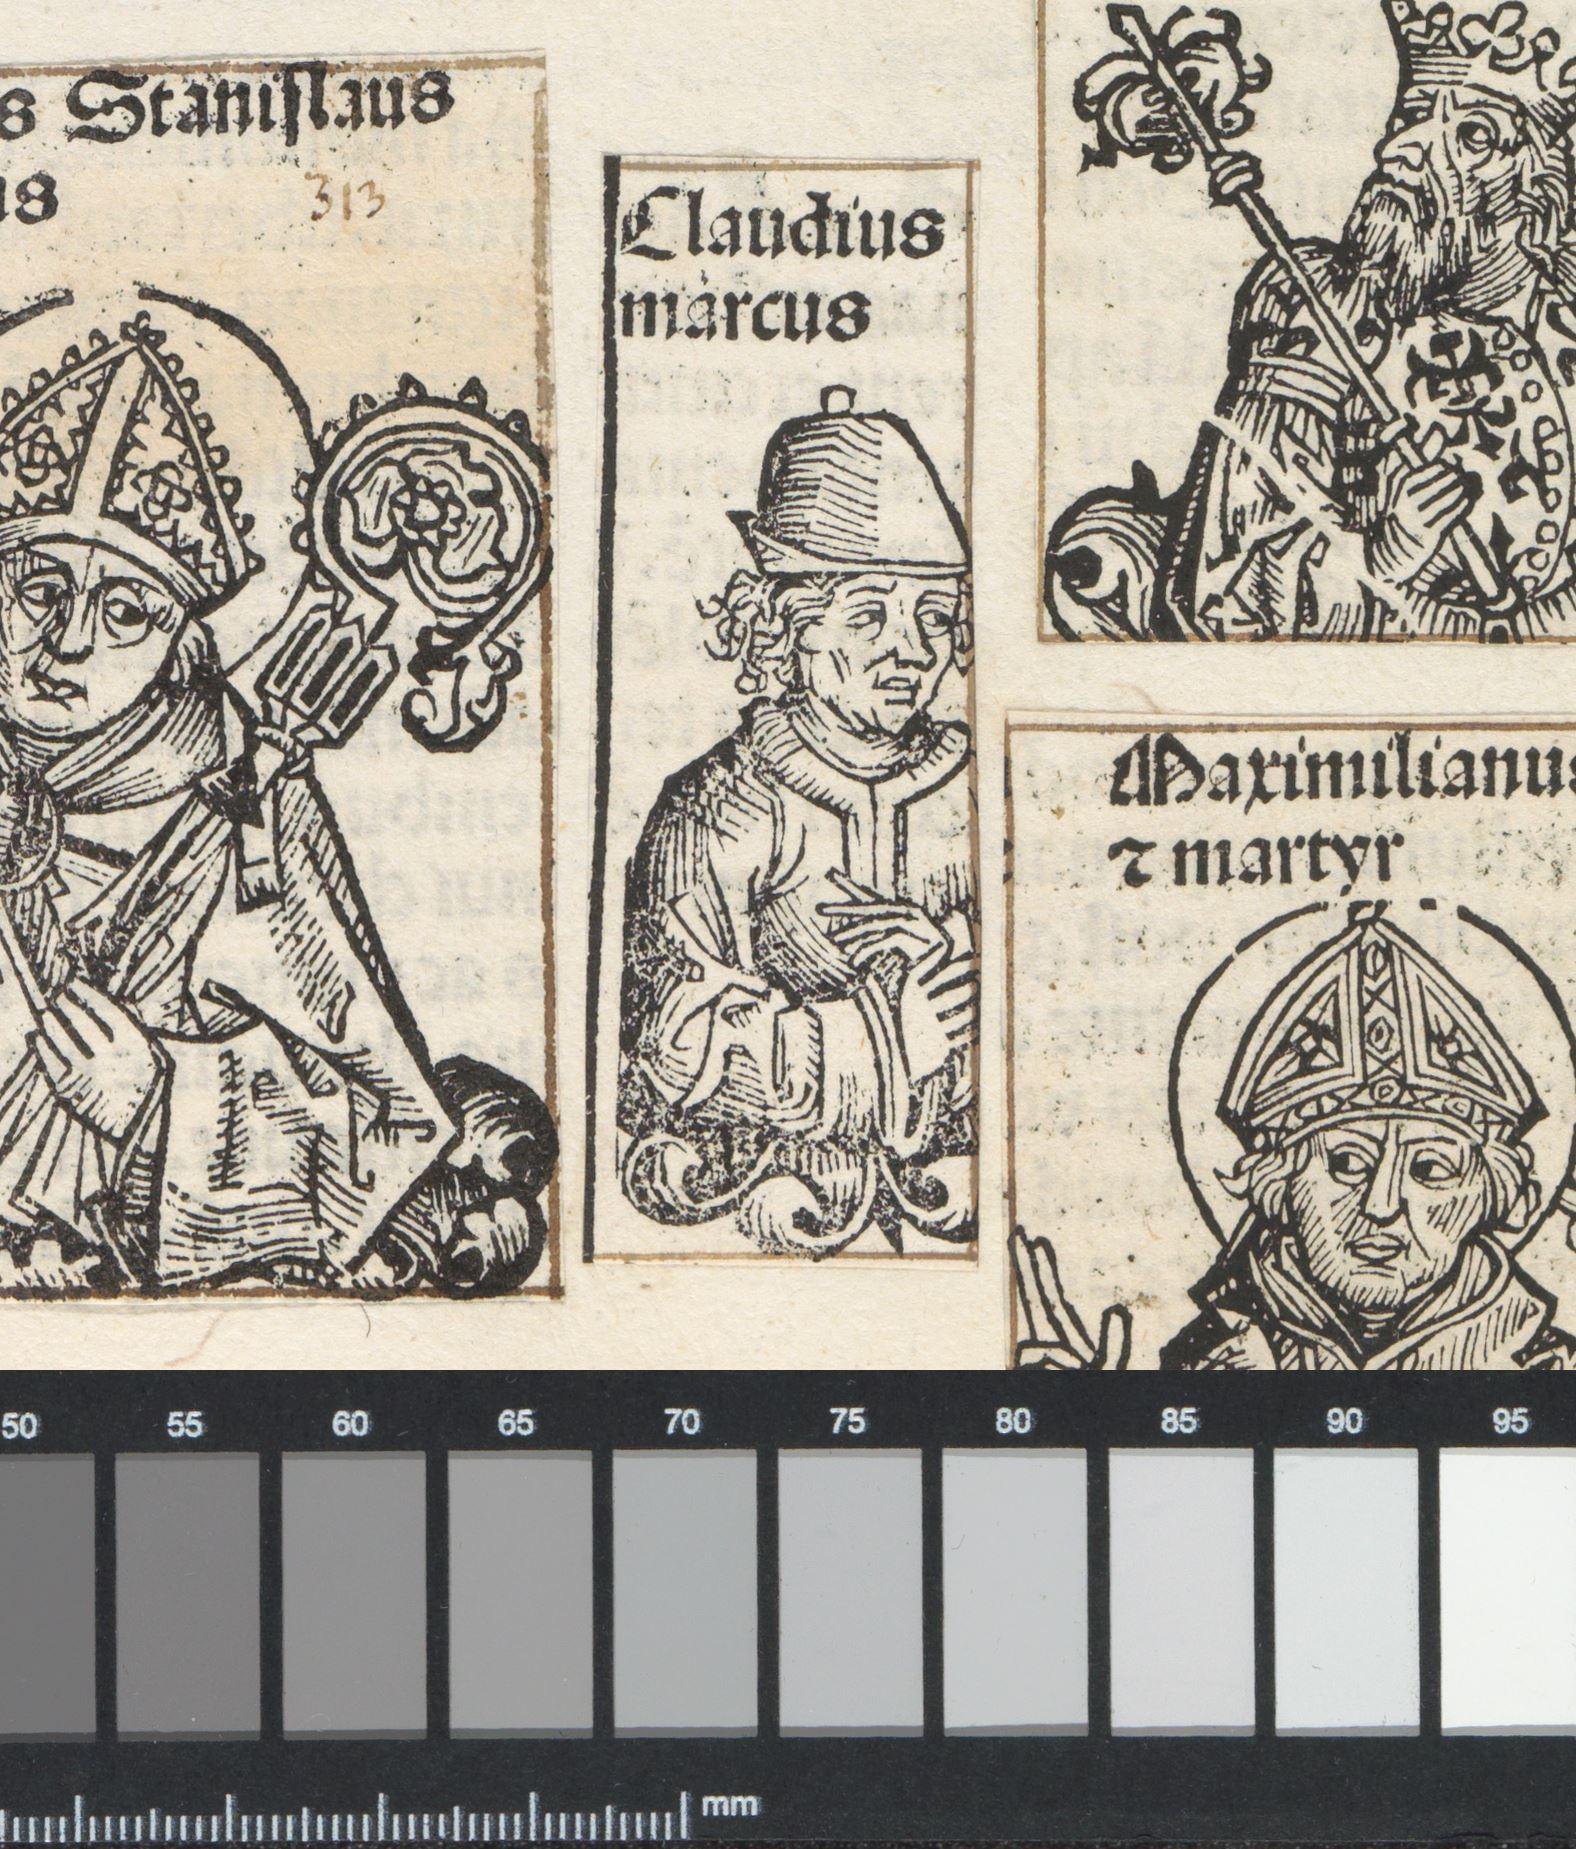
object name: album leaf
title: Liber Chronicarum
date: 1493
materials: paper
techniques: letterpress printing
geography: nuremberg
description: Een bloemkelk met een man. De voorstelling is een fragment uit de opeenvolging Romeinse consuls in de Liber Chronicarum. De tekst identificeert de man als Claudius Marcus. De prent maakt deel uit van een album.